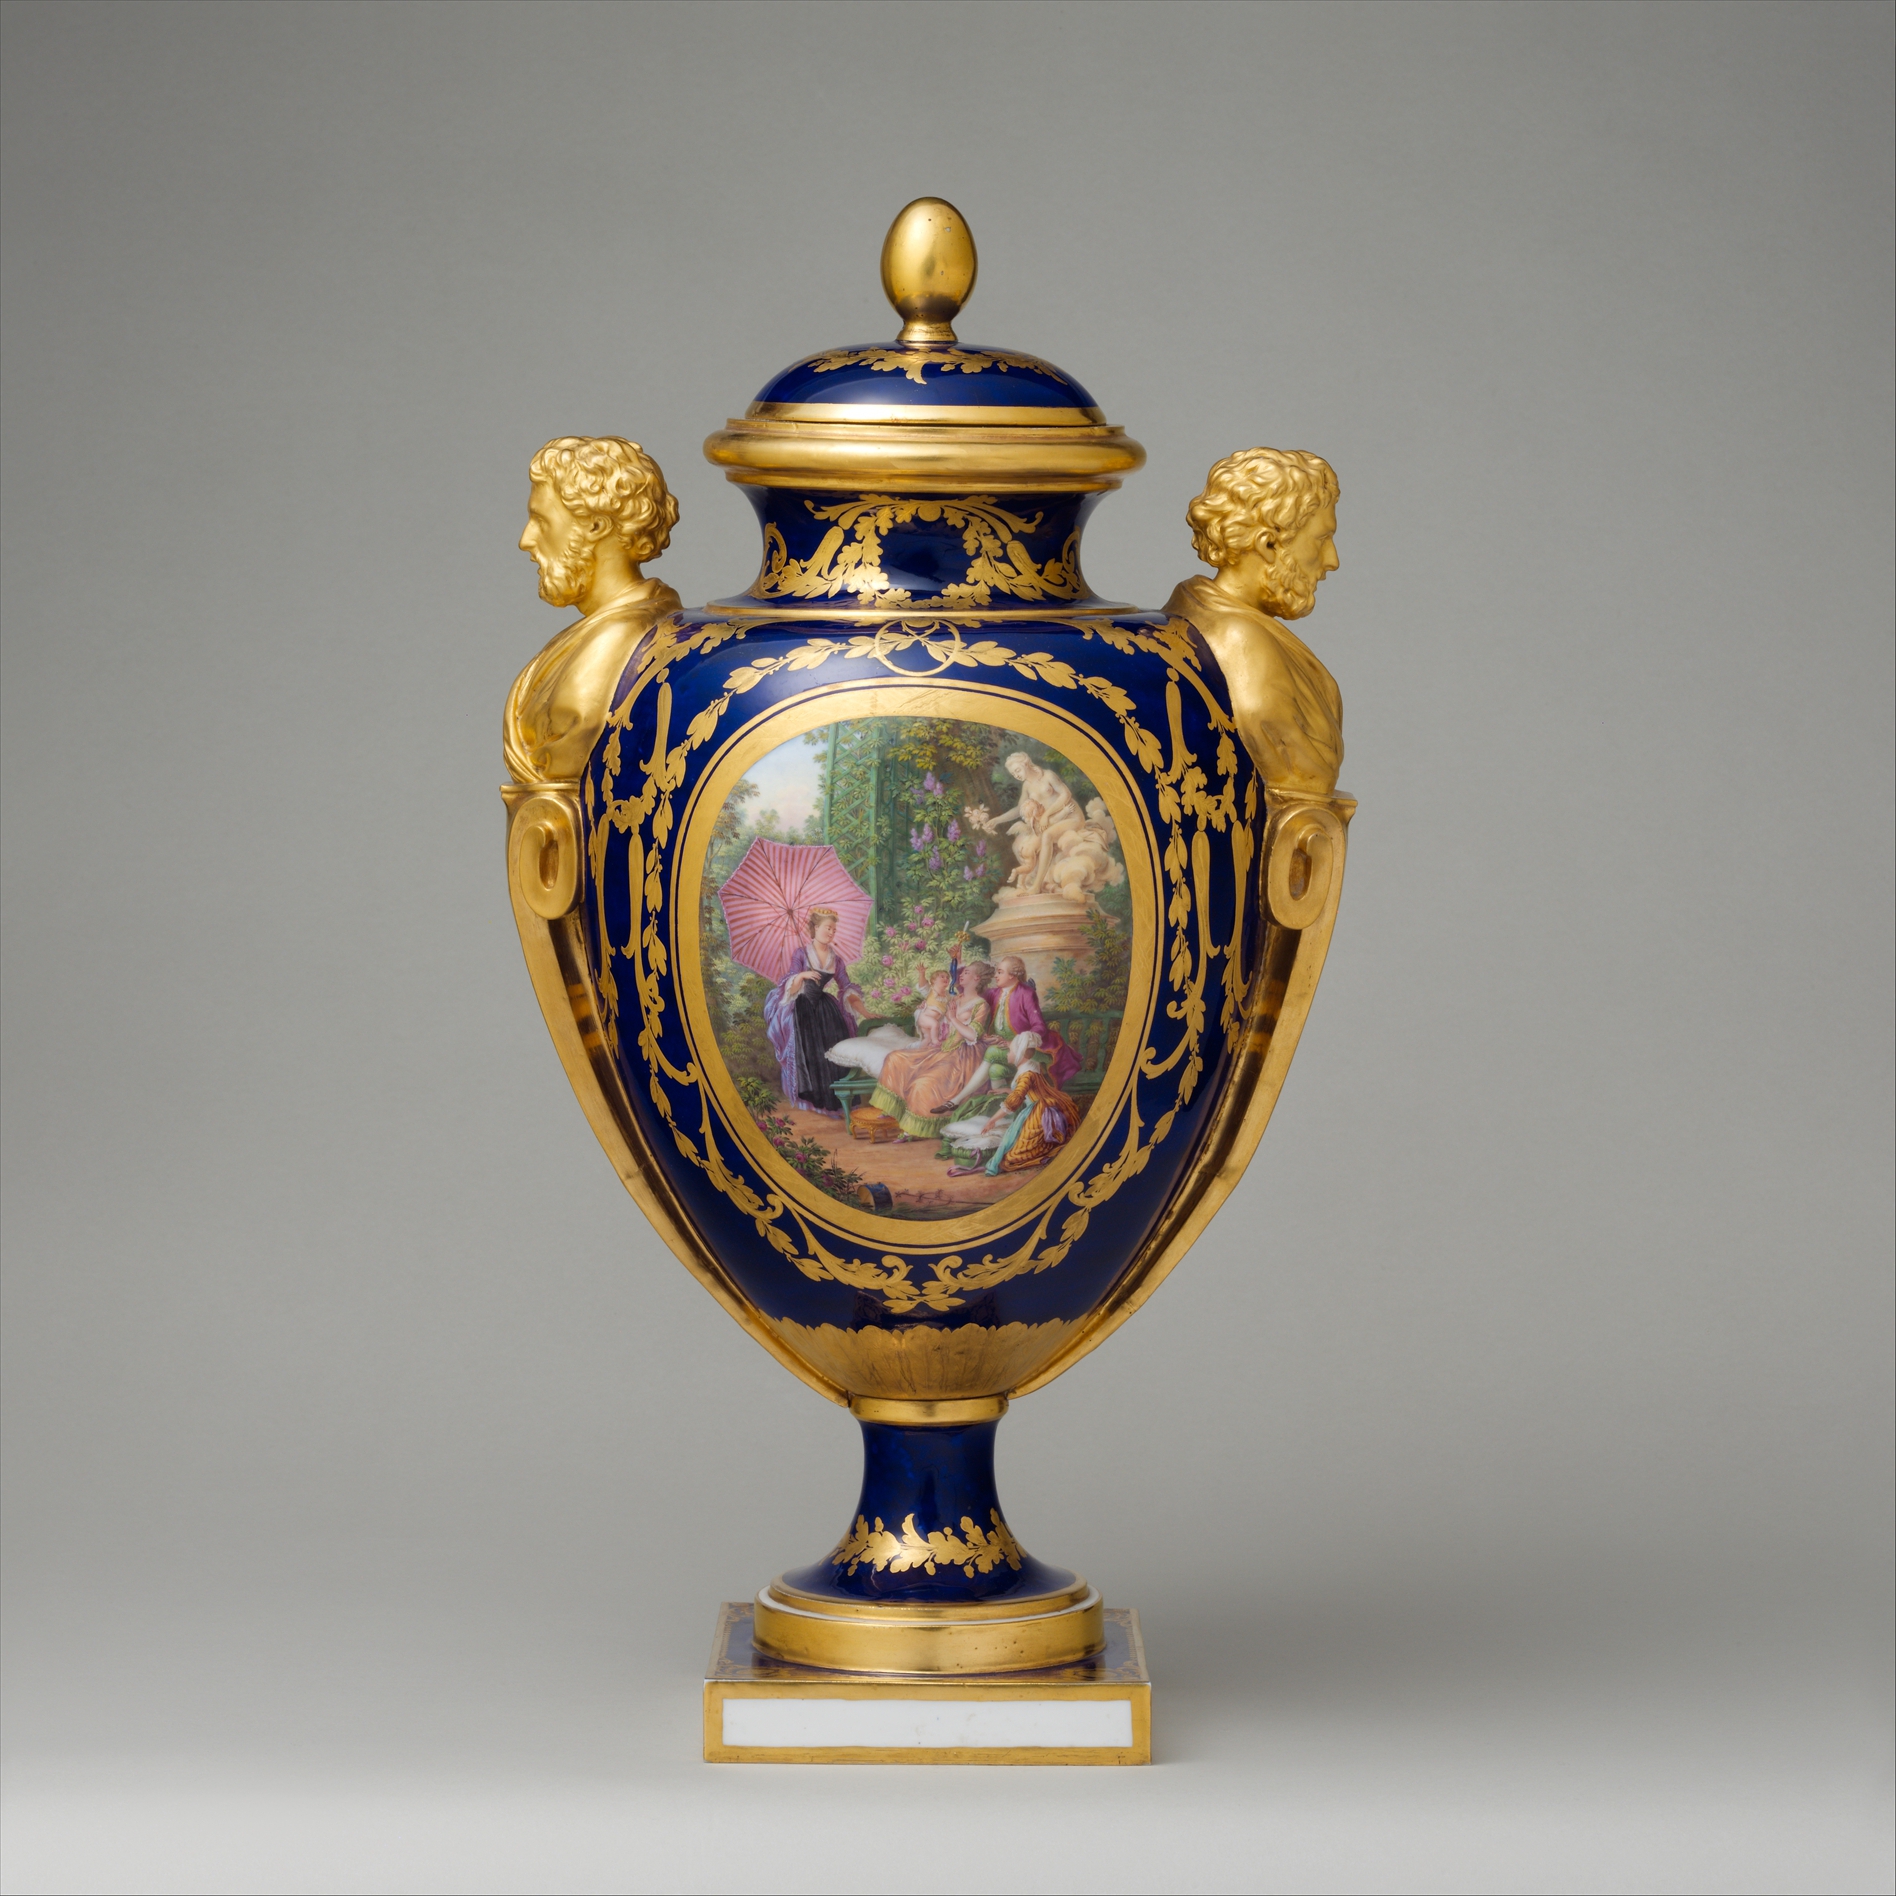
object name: vase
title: Vase with cover (vase des âges) (one of a pair)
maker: sèvres manufactory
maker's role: manufactory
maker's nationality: french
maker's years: 1740-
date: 1782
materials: enamel, gold, soft paste porcelain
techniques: polychrome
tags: men,women